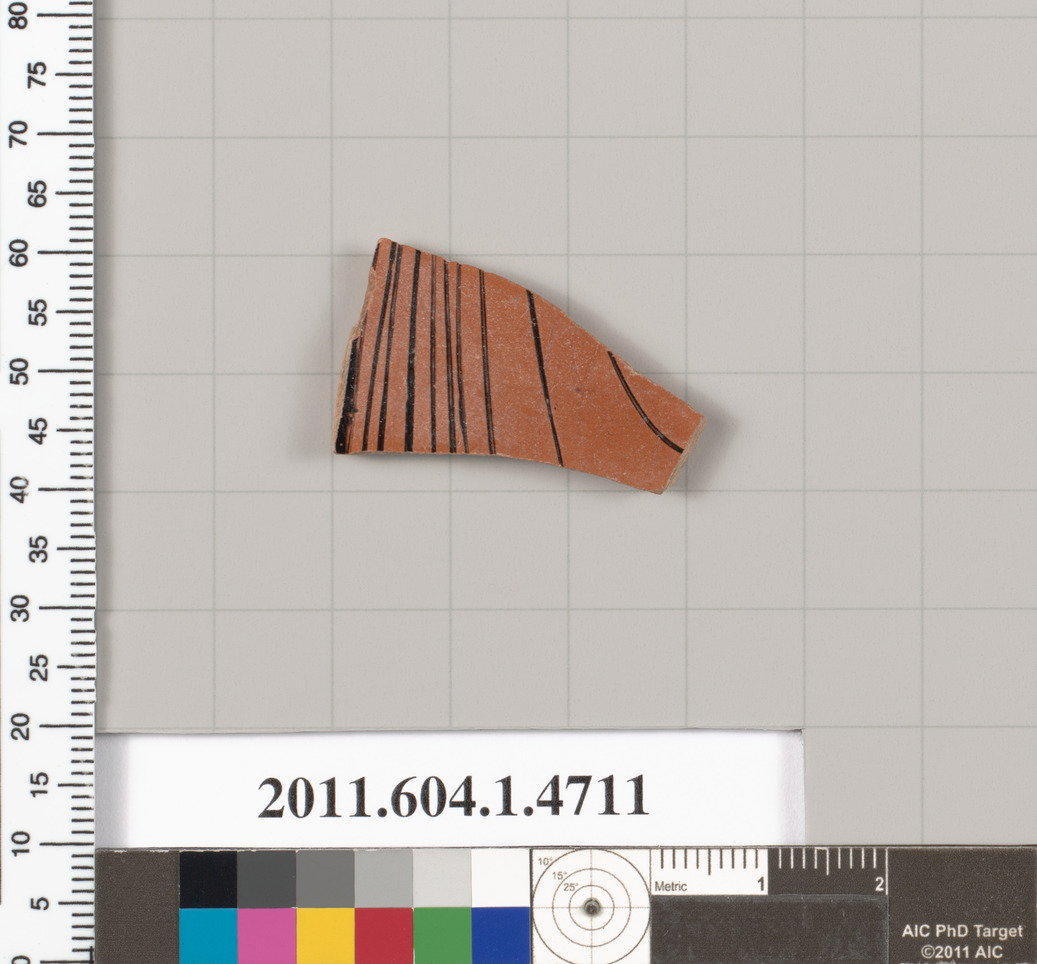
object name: kylix fragment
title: Terracotta fragment of a kylix (drinking cup)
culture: greek, attic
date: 475-451 BCE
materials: terracotta